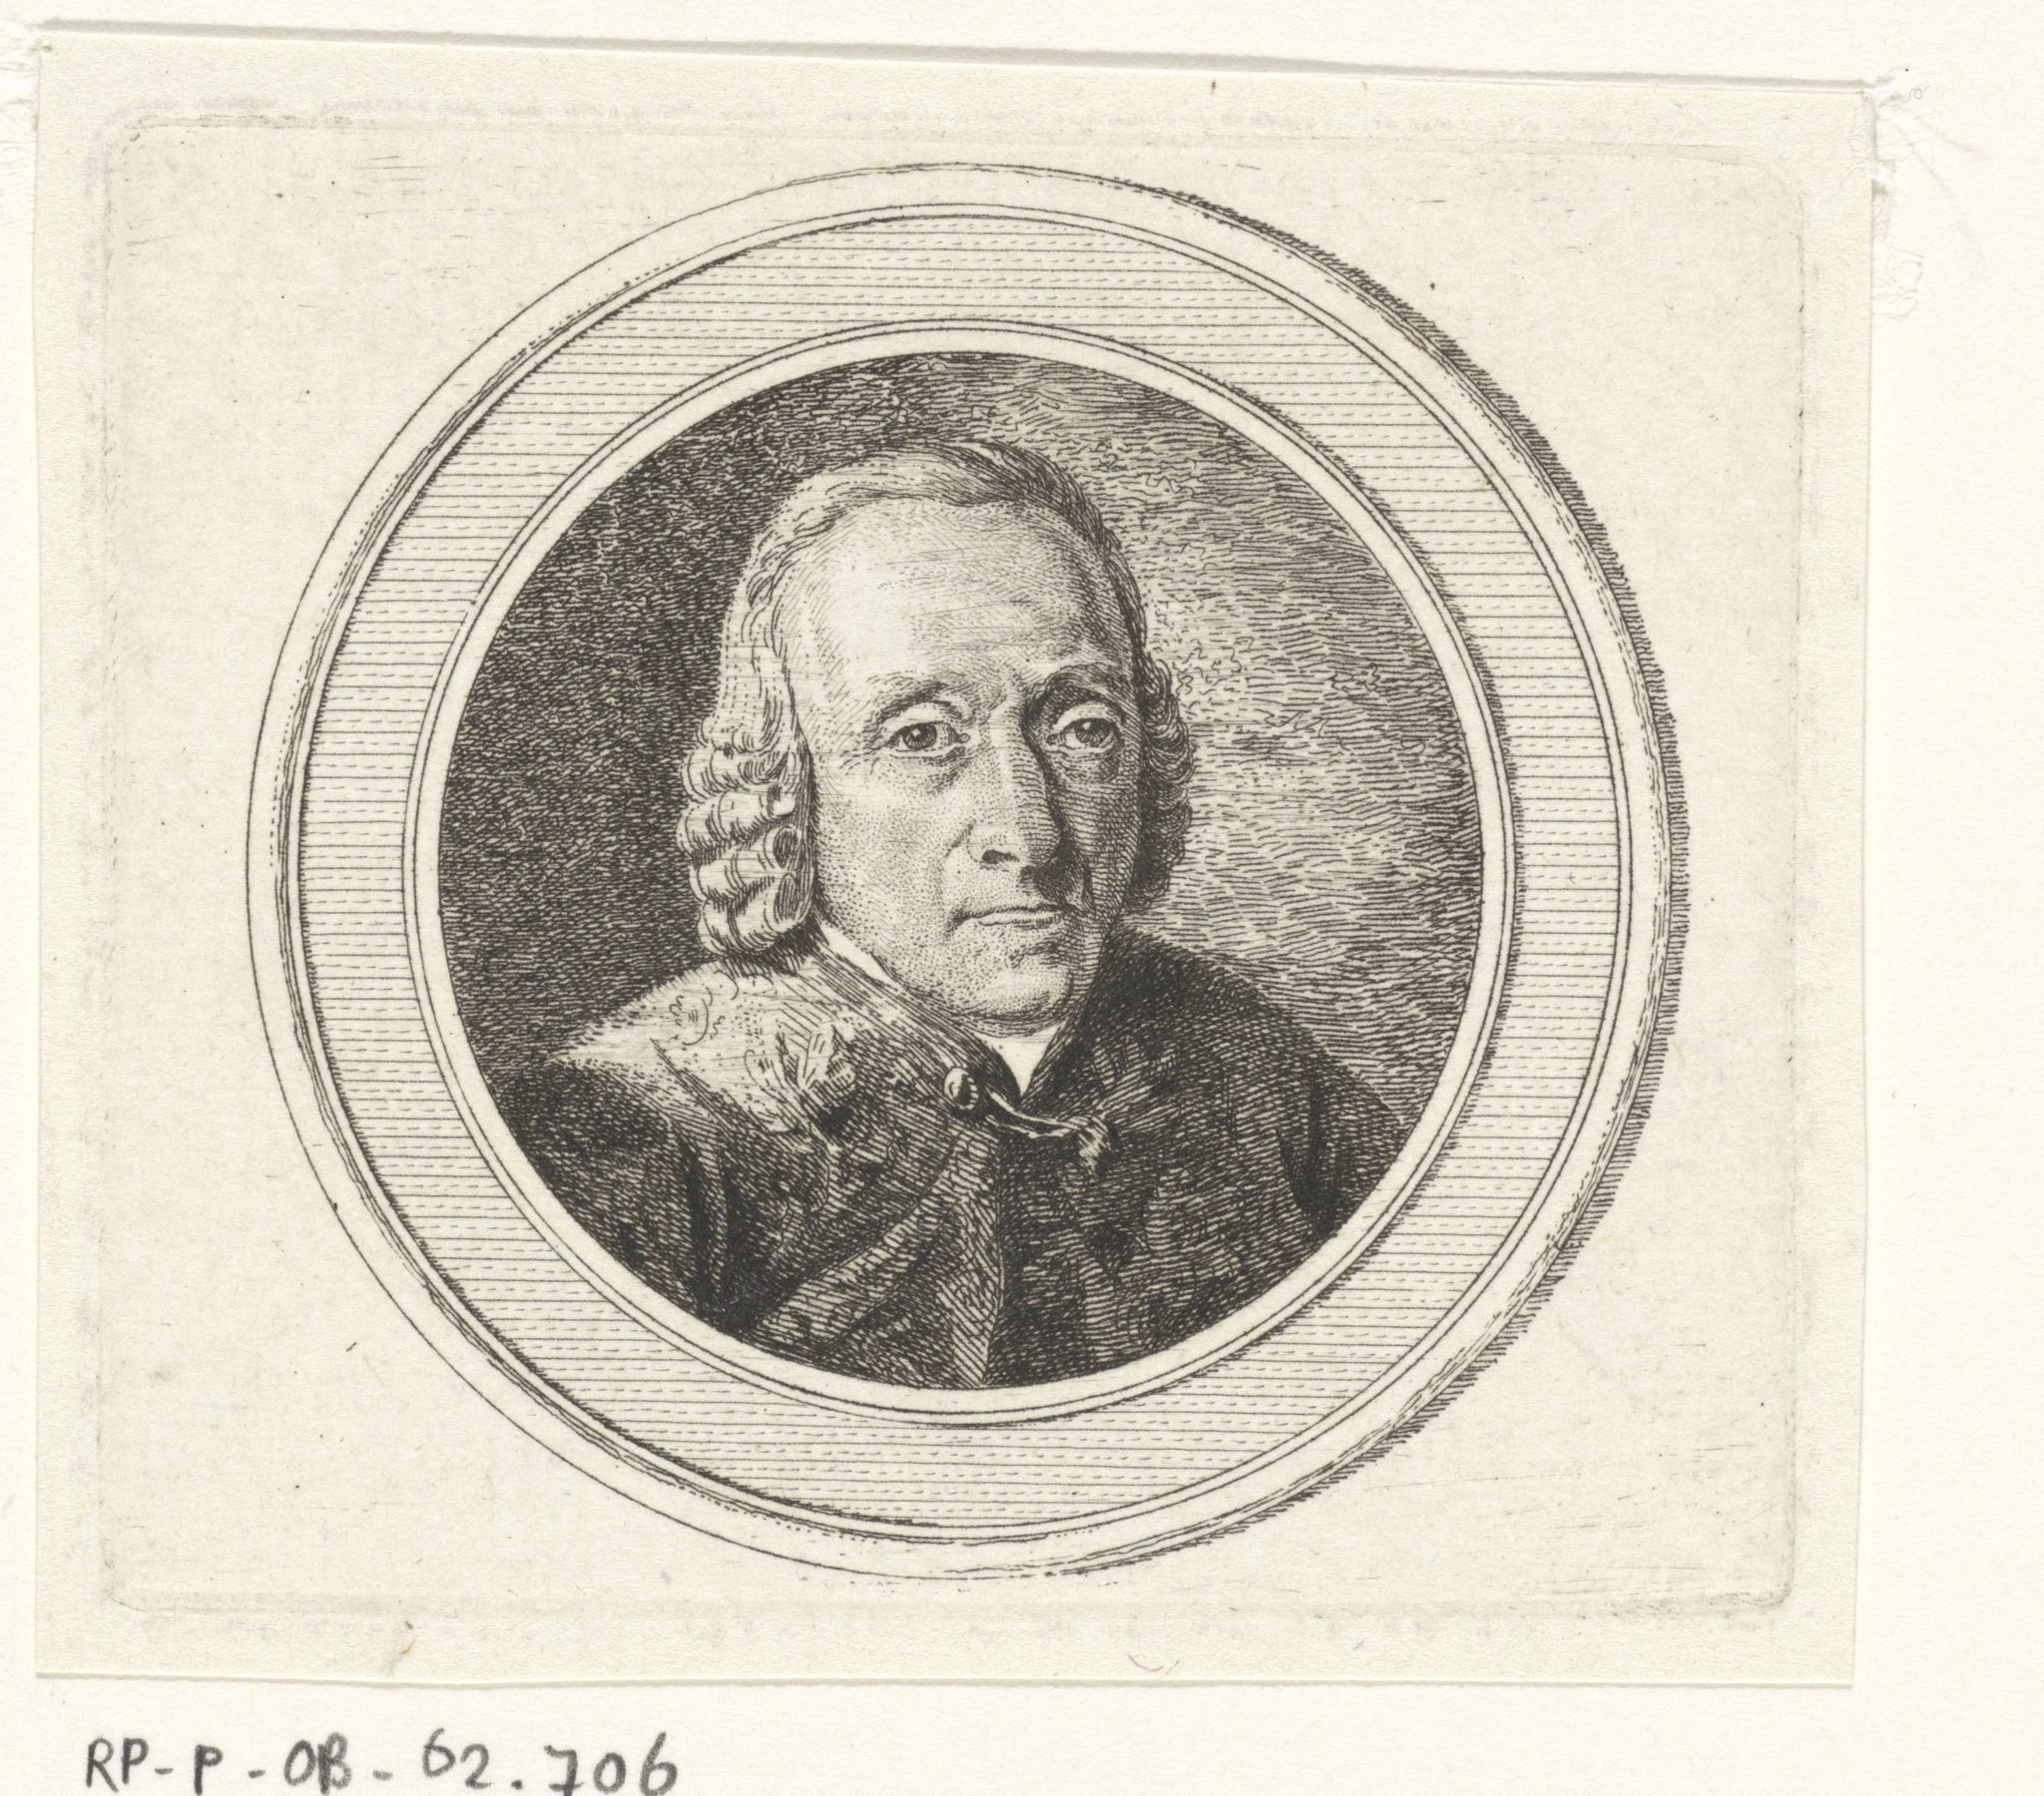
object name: print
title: Portret van Hendrik Busserus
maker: reinier vinkeles (i)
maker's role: draughtsman, print maker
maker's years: 1741-1816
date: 1781-1816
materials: paper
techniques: engraving, etching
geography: amsterdam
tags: amsterdam, print maker, hendrik busserus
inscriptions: collector's mark: Lugt 240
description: Portret van de kunstverzamelaar Hendrik Busserus.